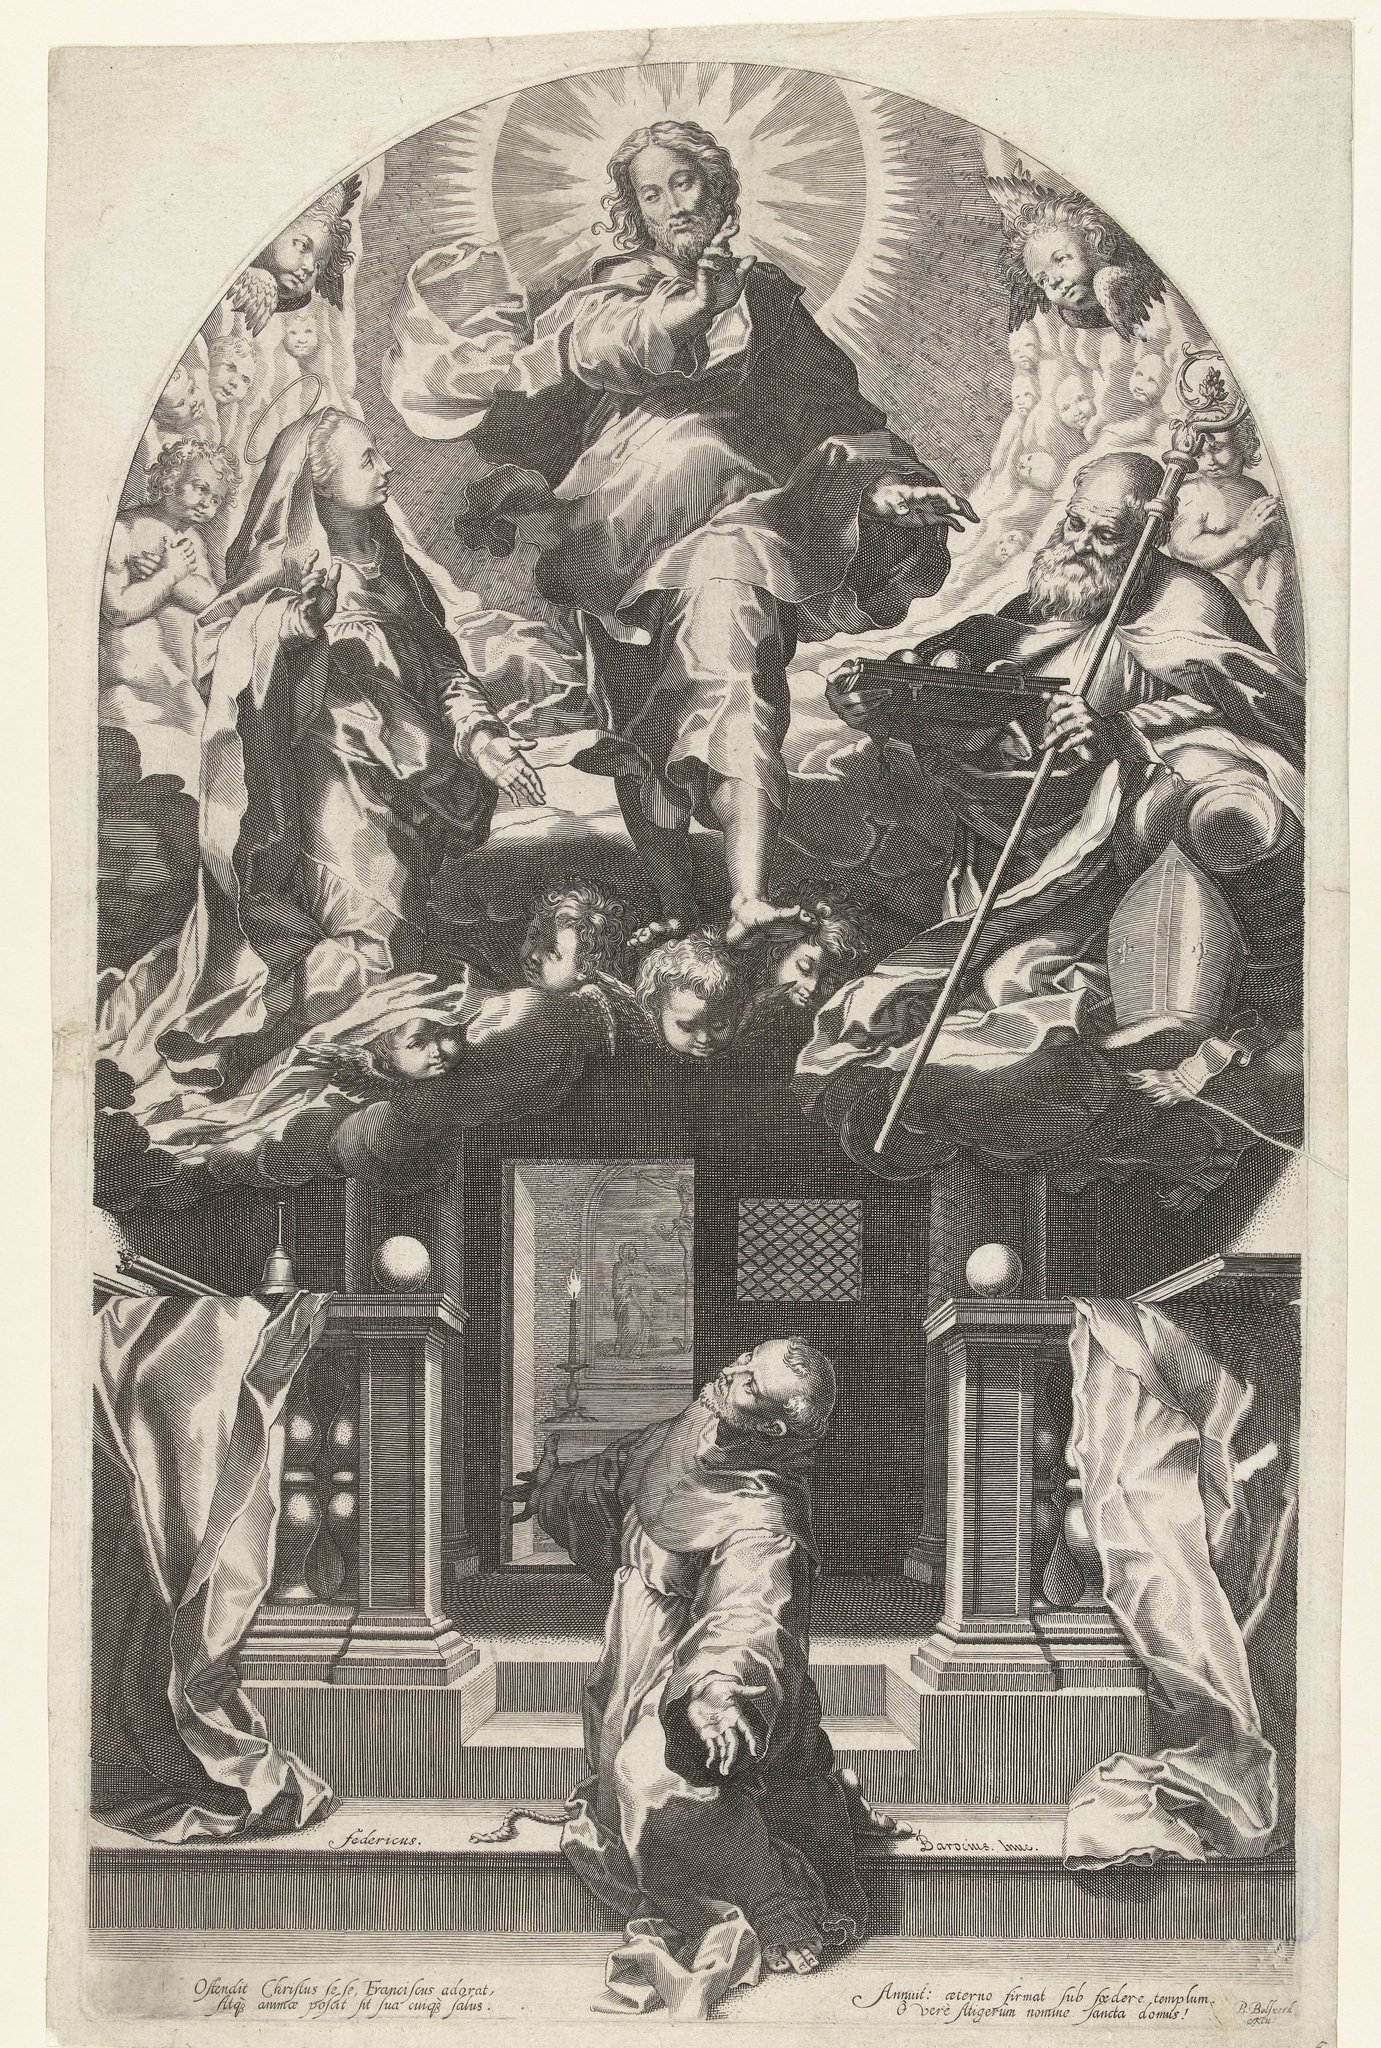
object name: print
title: Maria draagt heilige Franciscus van Assisi voor aan Christus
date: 1590-1633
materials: paper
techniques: engraving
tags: the virgin mary, interceding for mankind, presents st. dominic and usually also st. francis of assisi to christ; christ brandishes three spears or arrows to destroy the sins of pride, avarice and lust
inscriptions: inscription: ‘B. 25 f 100-103’, collector's mark: Lugt 11, collector's mark: Lugt 10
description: De heilige Franciscus van Assisi knielt in een kerk en boven hem verschijnen Christus en Maria met engelenkoren. Maria treedt op als voorspraak van de mensheid en stelt Franciscus voor aan Christus. Naast Christus zit een heilige met kromstaf, mijter en boek, mogelijk de heilige Dominicus. Op het boek liggen drie voorwerpen waar Christus zijn zegen over uitspreekt, deze kunnen symbool staan voor de deugden gehoorzaamheid, armoede en kuisheid. Onder de voorstelling staat een Latijns vers.